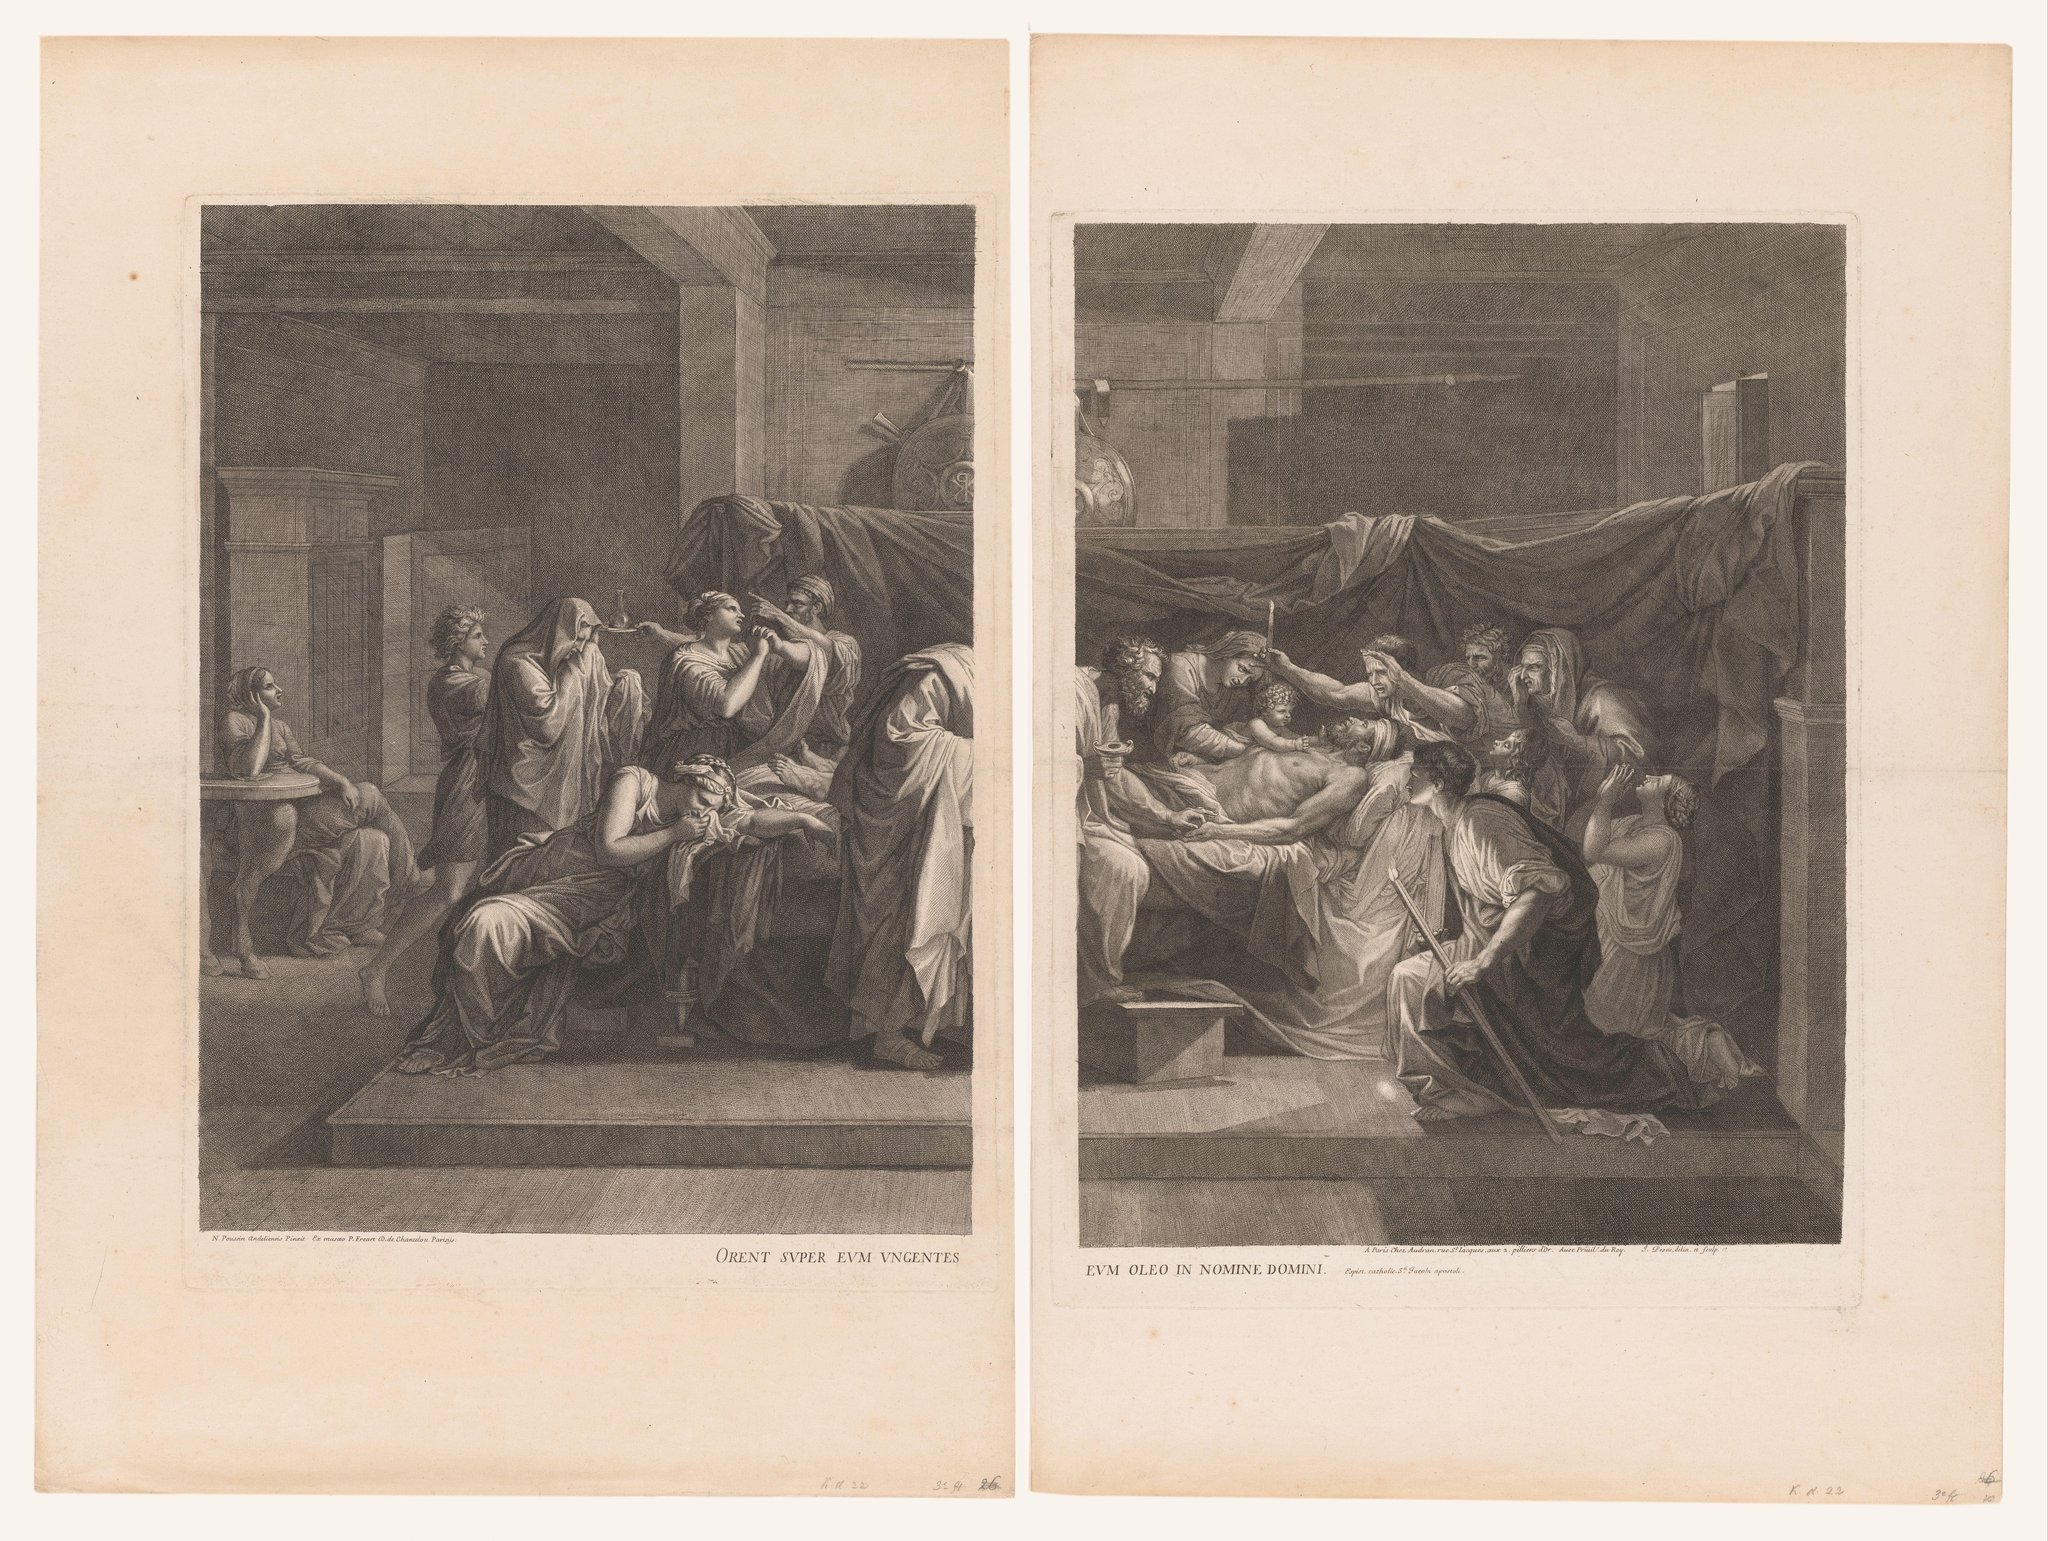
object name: print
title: Orent super eum urgentes eum oleo in nomine domini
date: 1680-1694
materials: paper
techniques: etching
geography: paris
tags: extreme unction ~ the last of the seven sacraments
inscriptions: collector's mark: Lugt 240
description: Prent maakt deel uit van een ongenummerde serie van zeven prenten. Dit object is omwille van een betere presentatie virtueel samengevoegd, maar bestaat fysiek uit losse onderdelen.